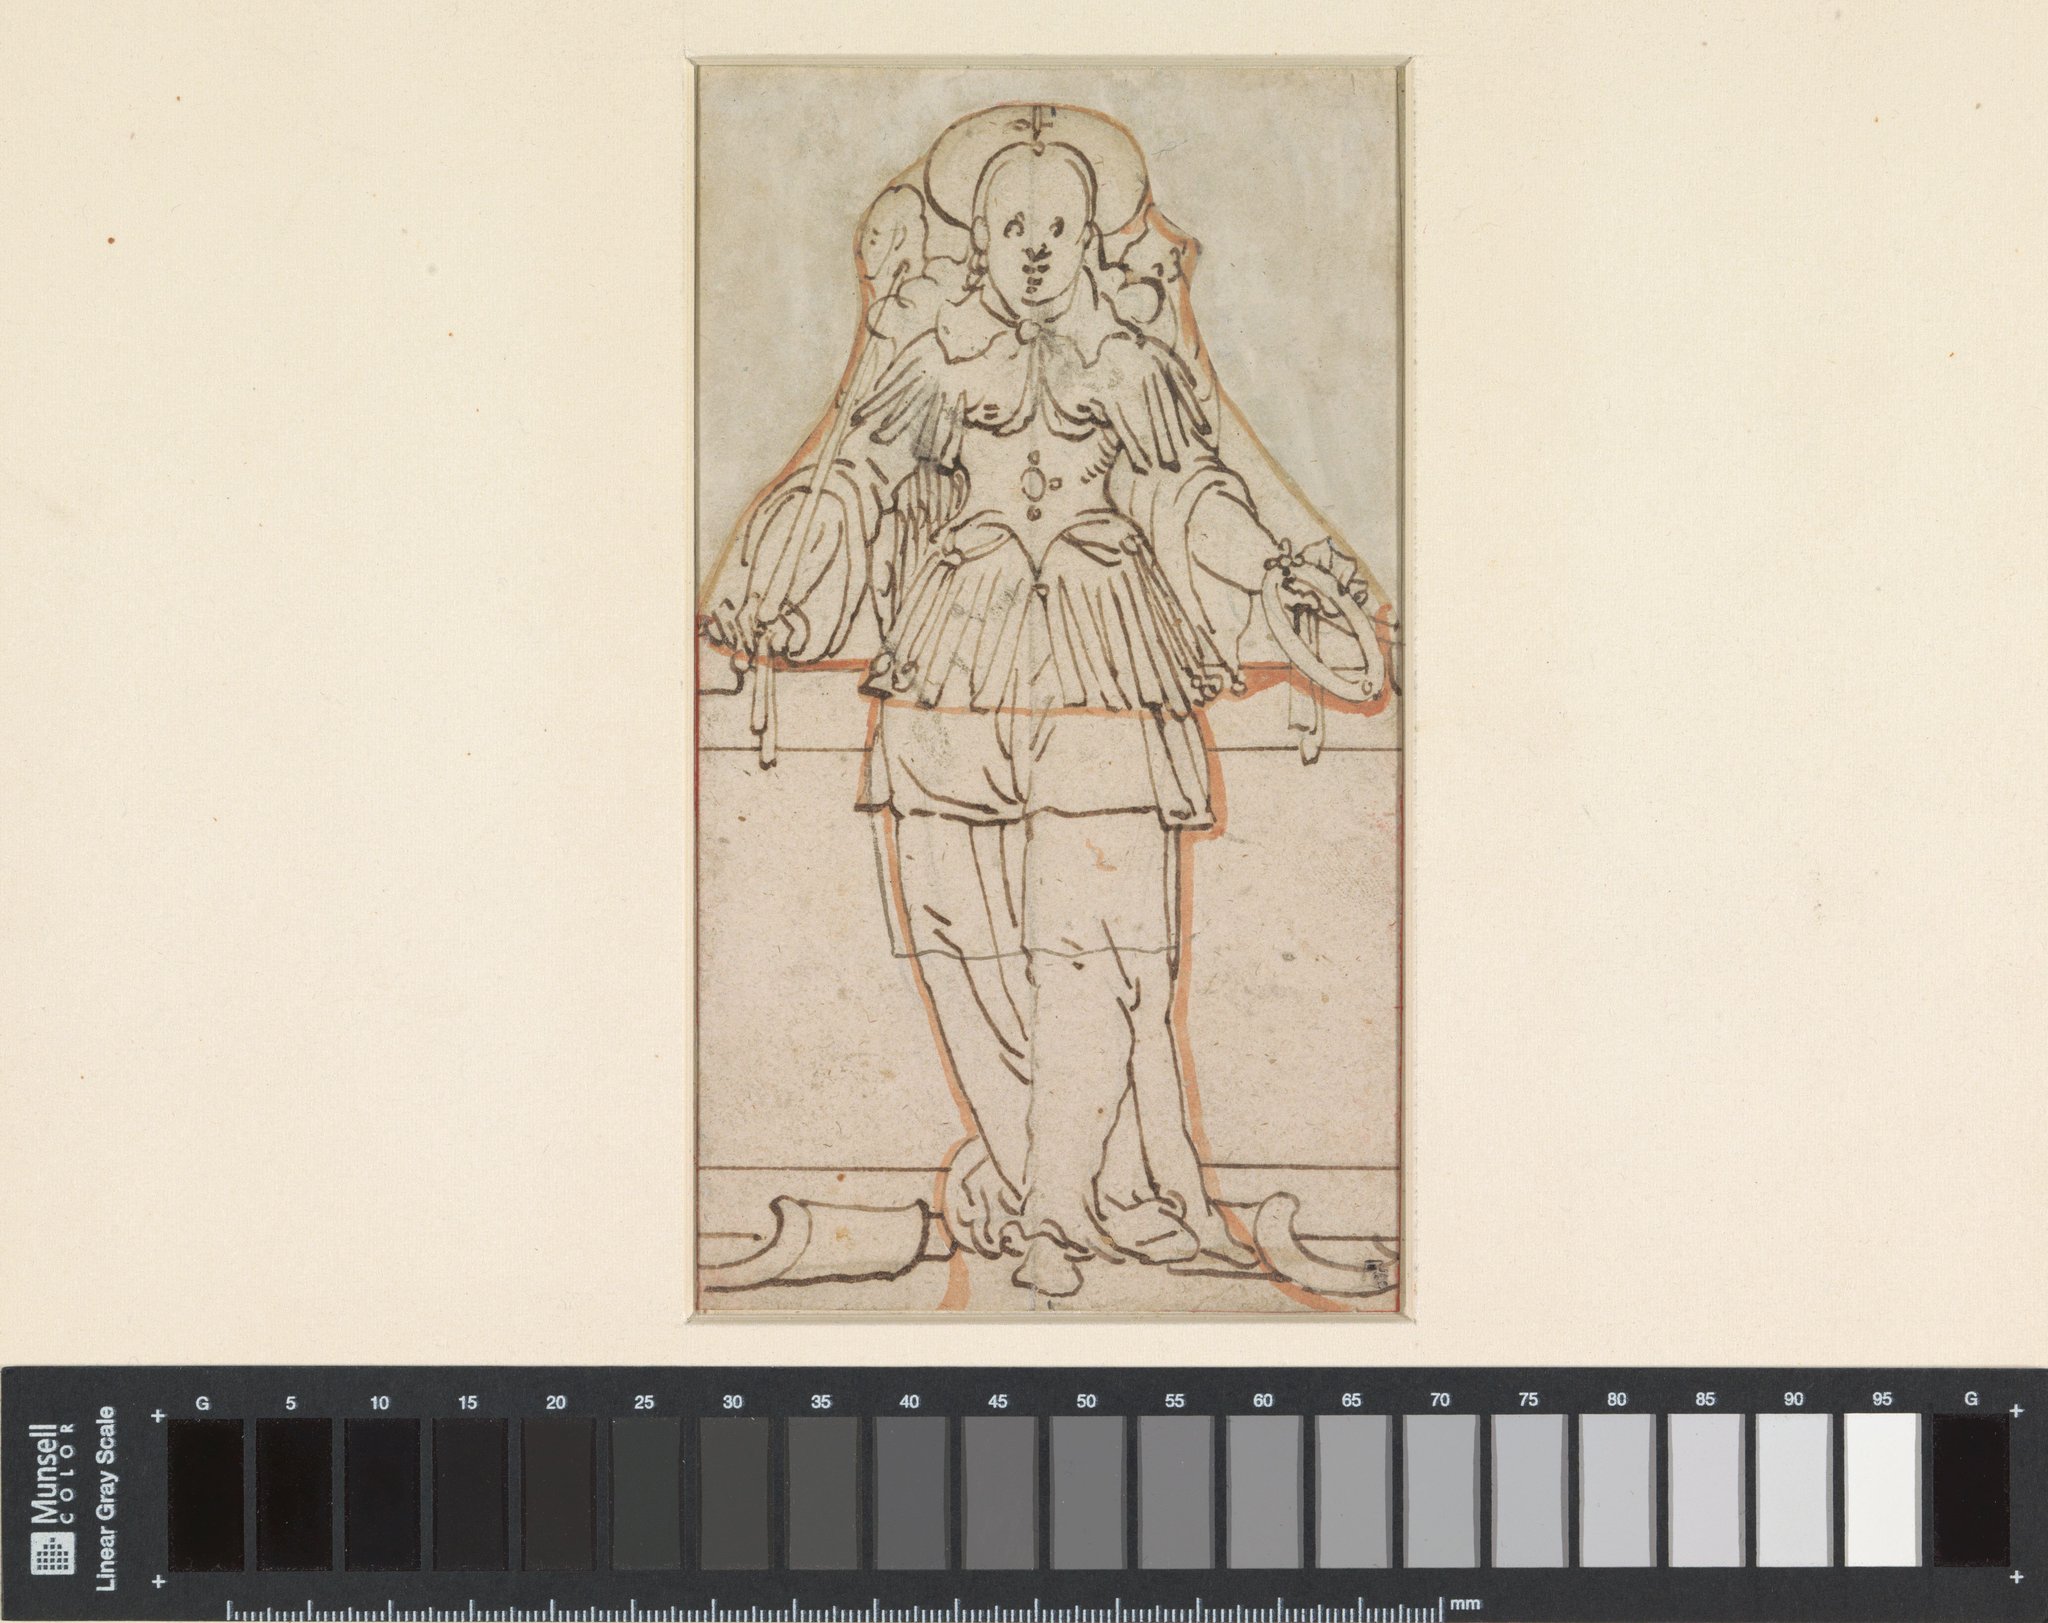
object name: drawing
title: Engel: staande allegorische figuur en face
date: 1600-1699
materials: ink, paper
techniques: brush, pen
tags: angels